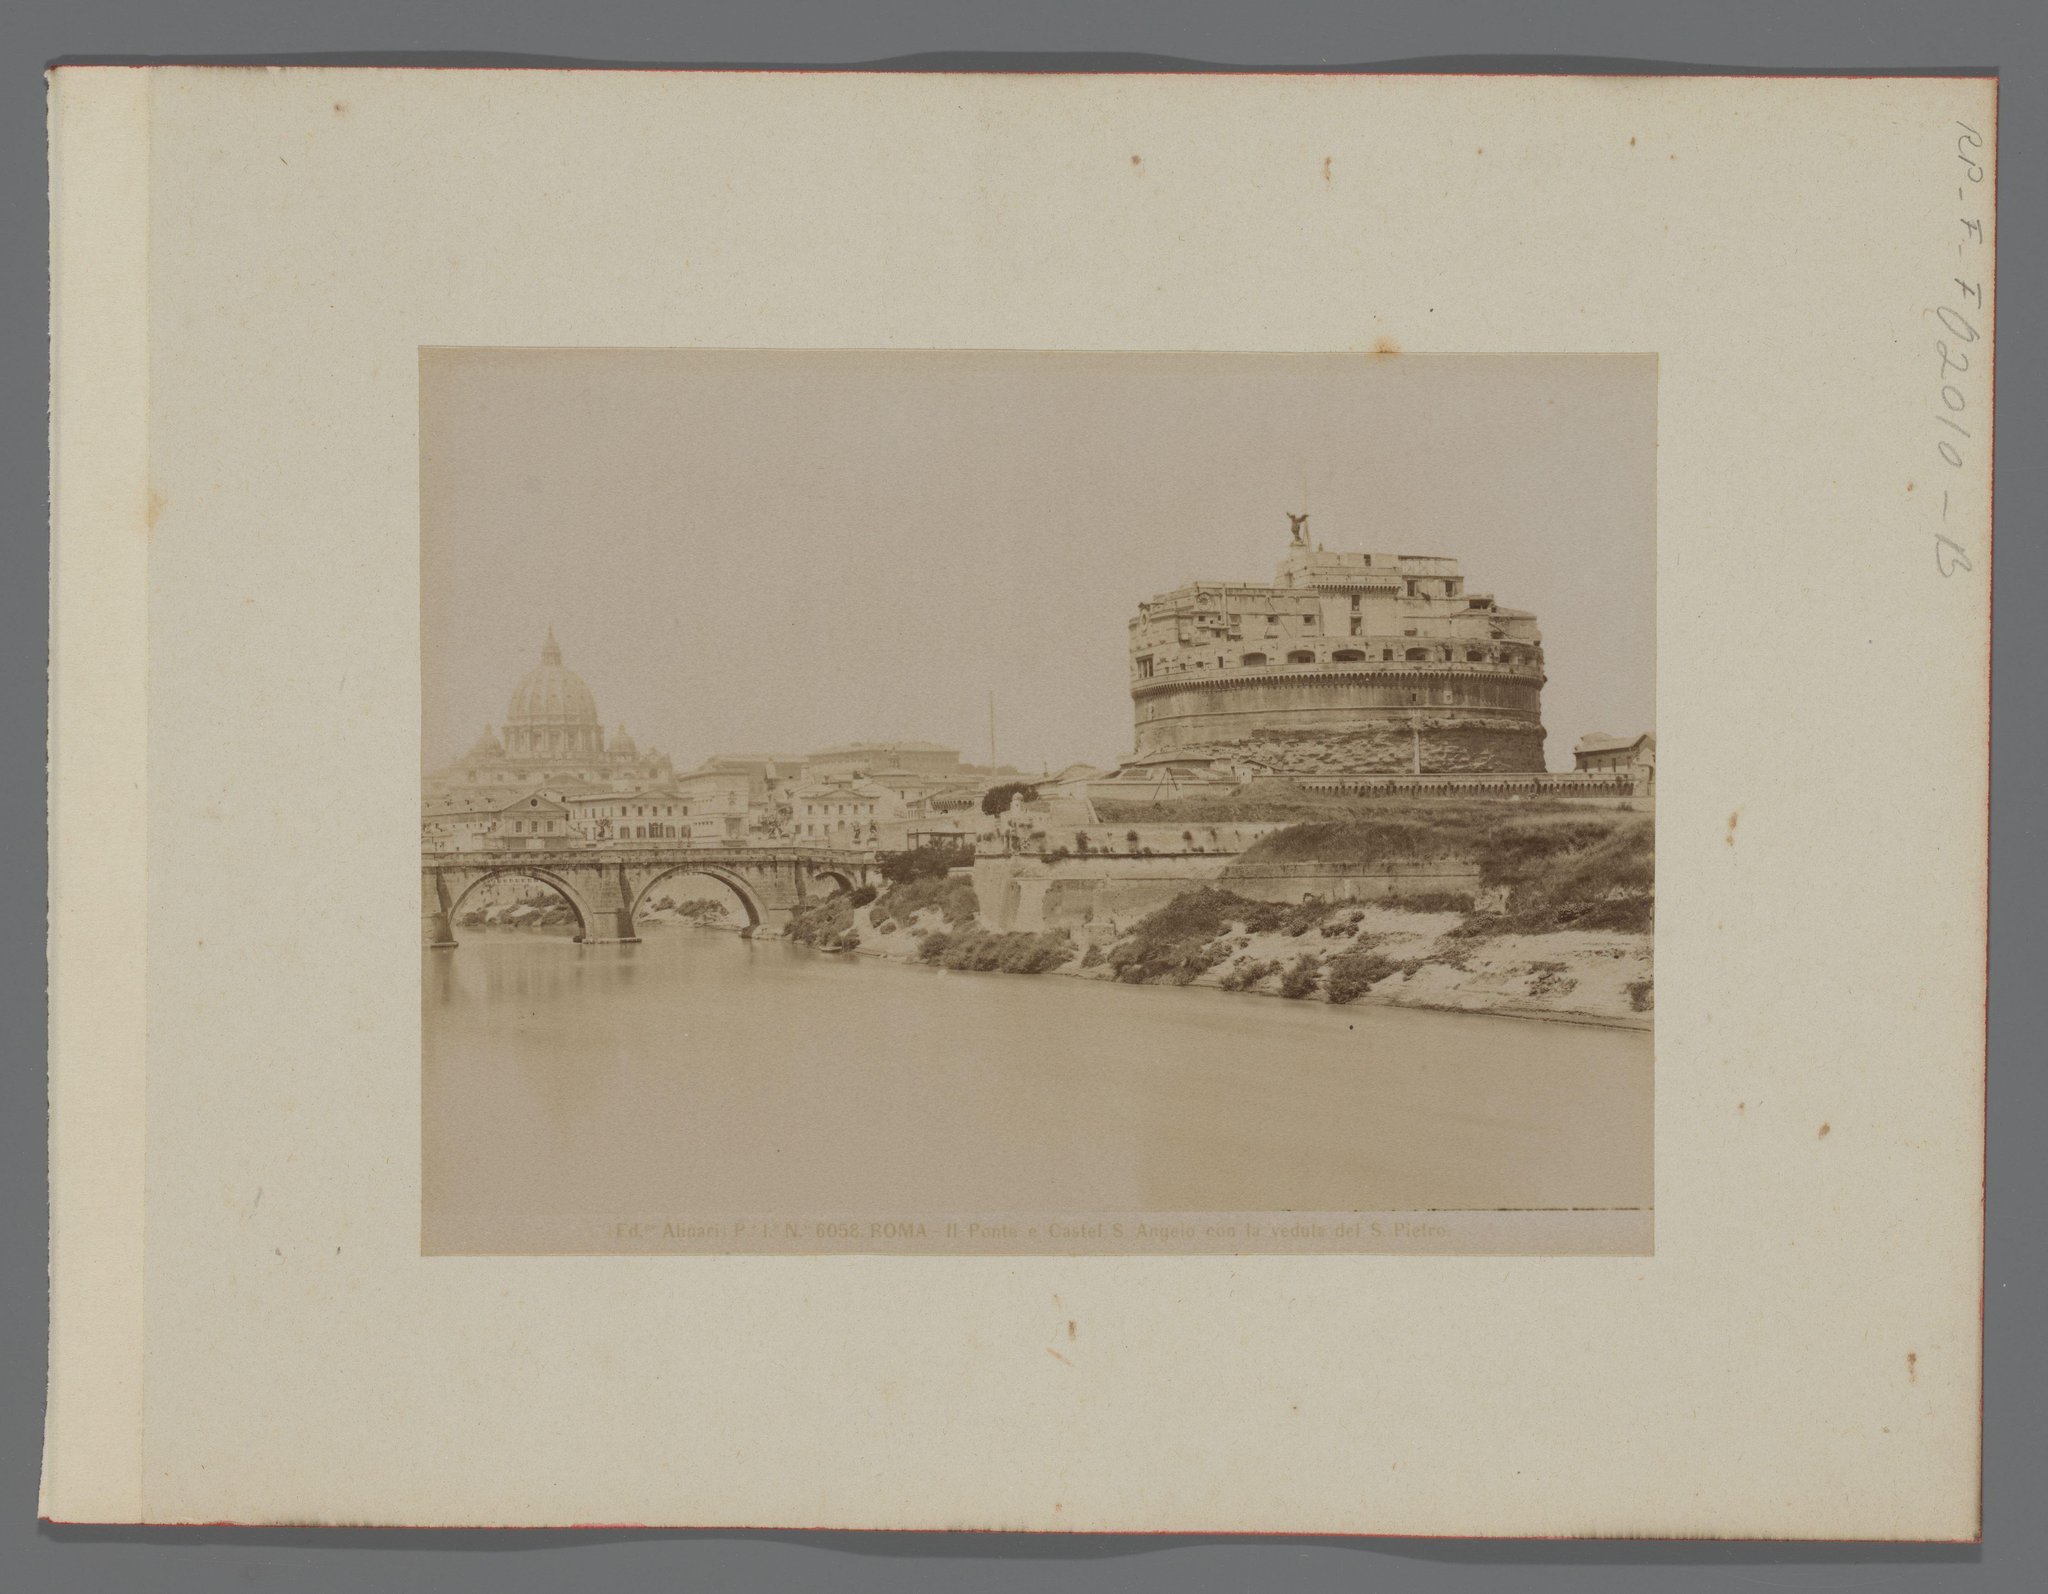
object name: photograph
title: Engelenburcht te Rome met links een deel van de Engelenbrug, Italië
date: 1852-1900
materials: cardboard, paper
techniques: albumen print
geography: rome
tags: castle, river, bridge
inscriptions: number: ‘Pe. Ia. No. 6058.’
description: Op de achtergrond is de koepel van de Sint Pieter te zien.